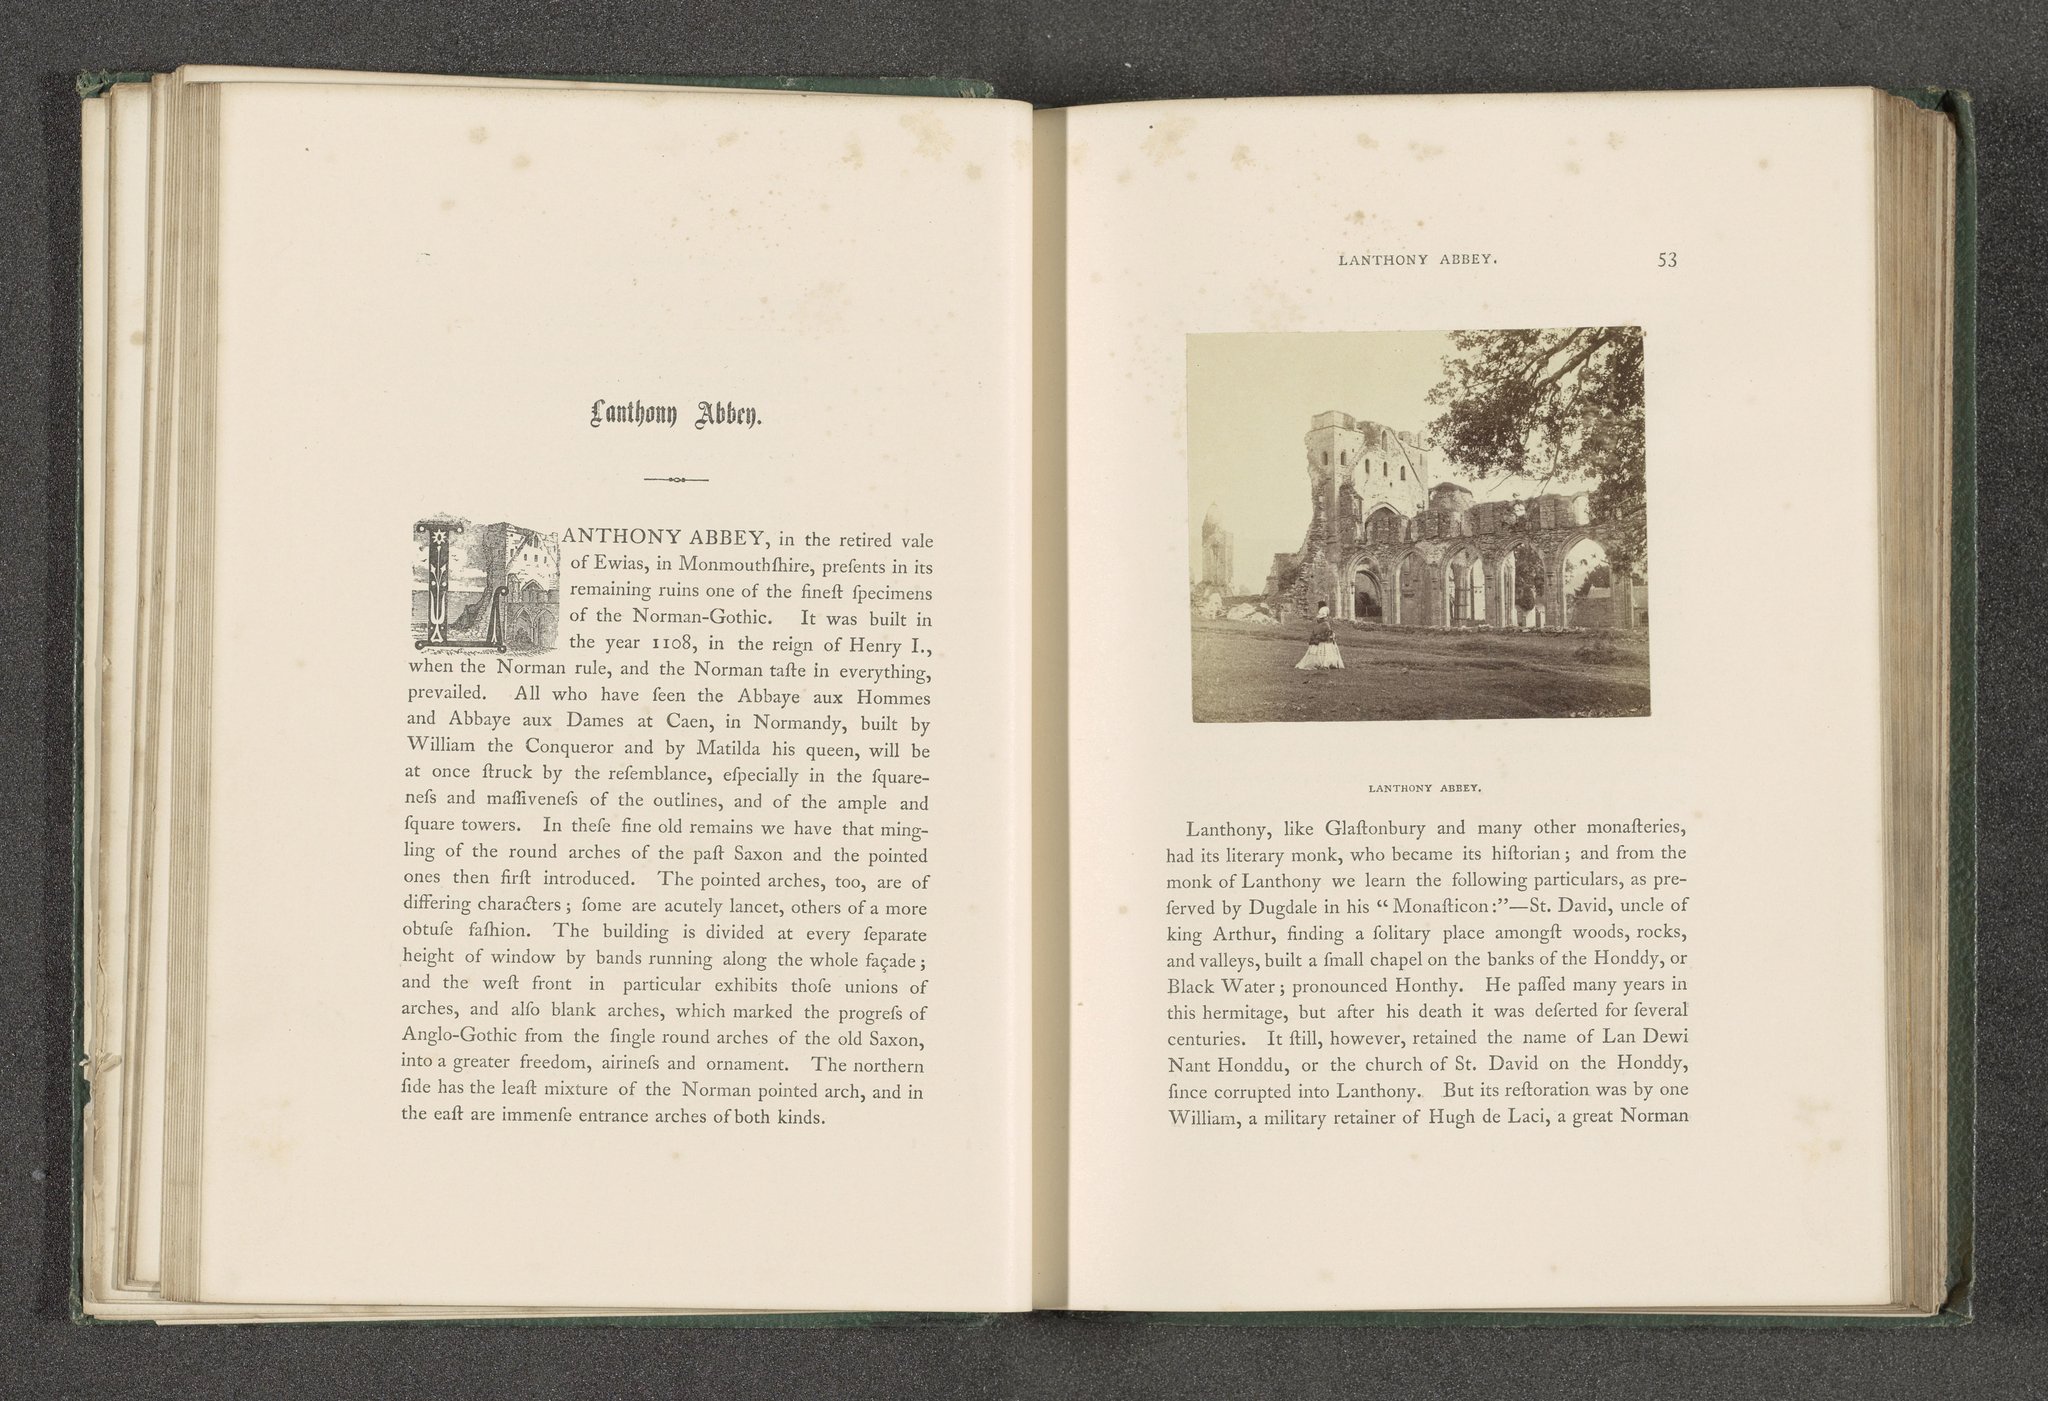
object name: page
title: Gezicht op de ruïne van Llanthony Priory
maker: francis bedford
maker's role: print maker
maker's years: 1815-1894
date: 1852-1862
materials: photographic support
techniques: albumen print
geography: llanthony priory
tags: ruin of church, monastery, etc.